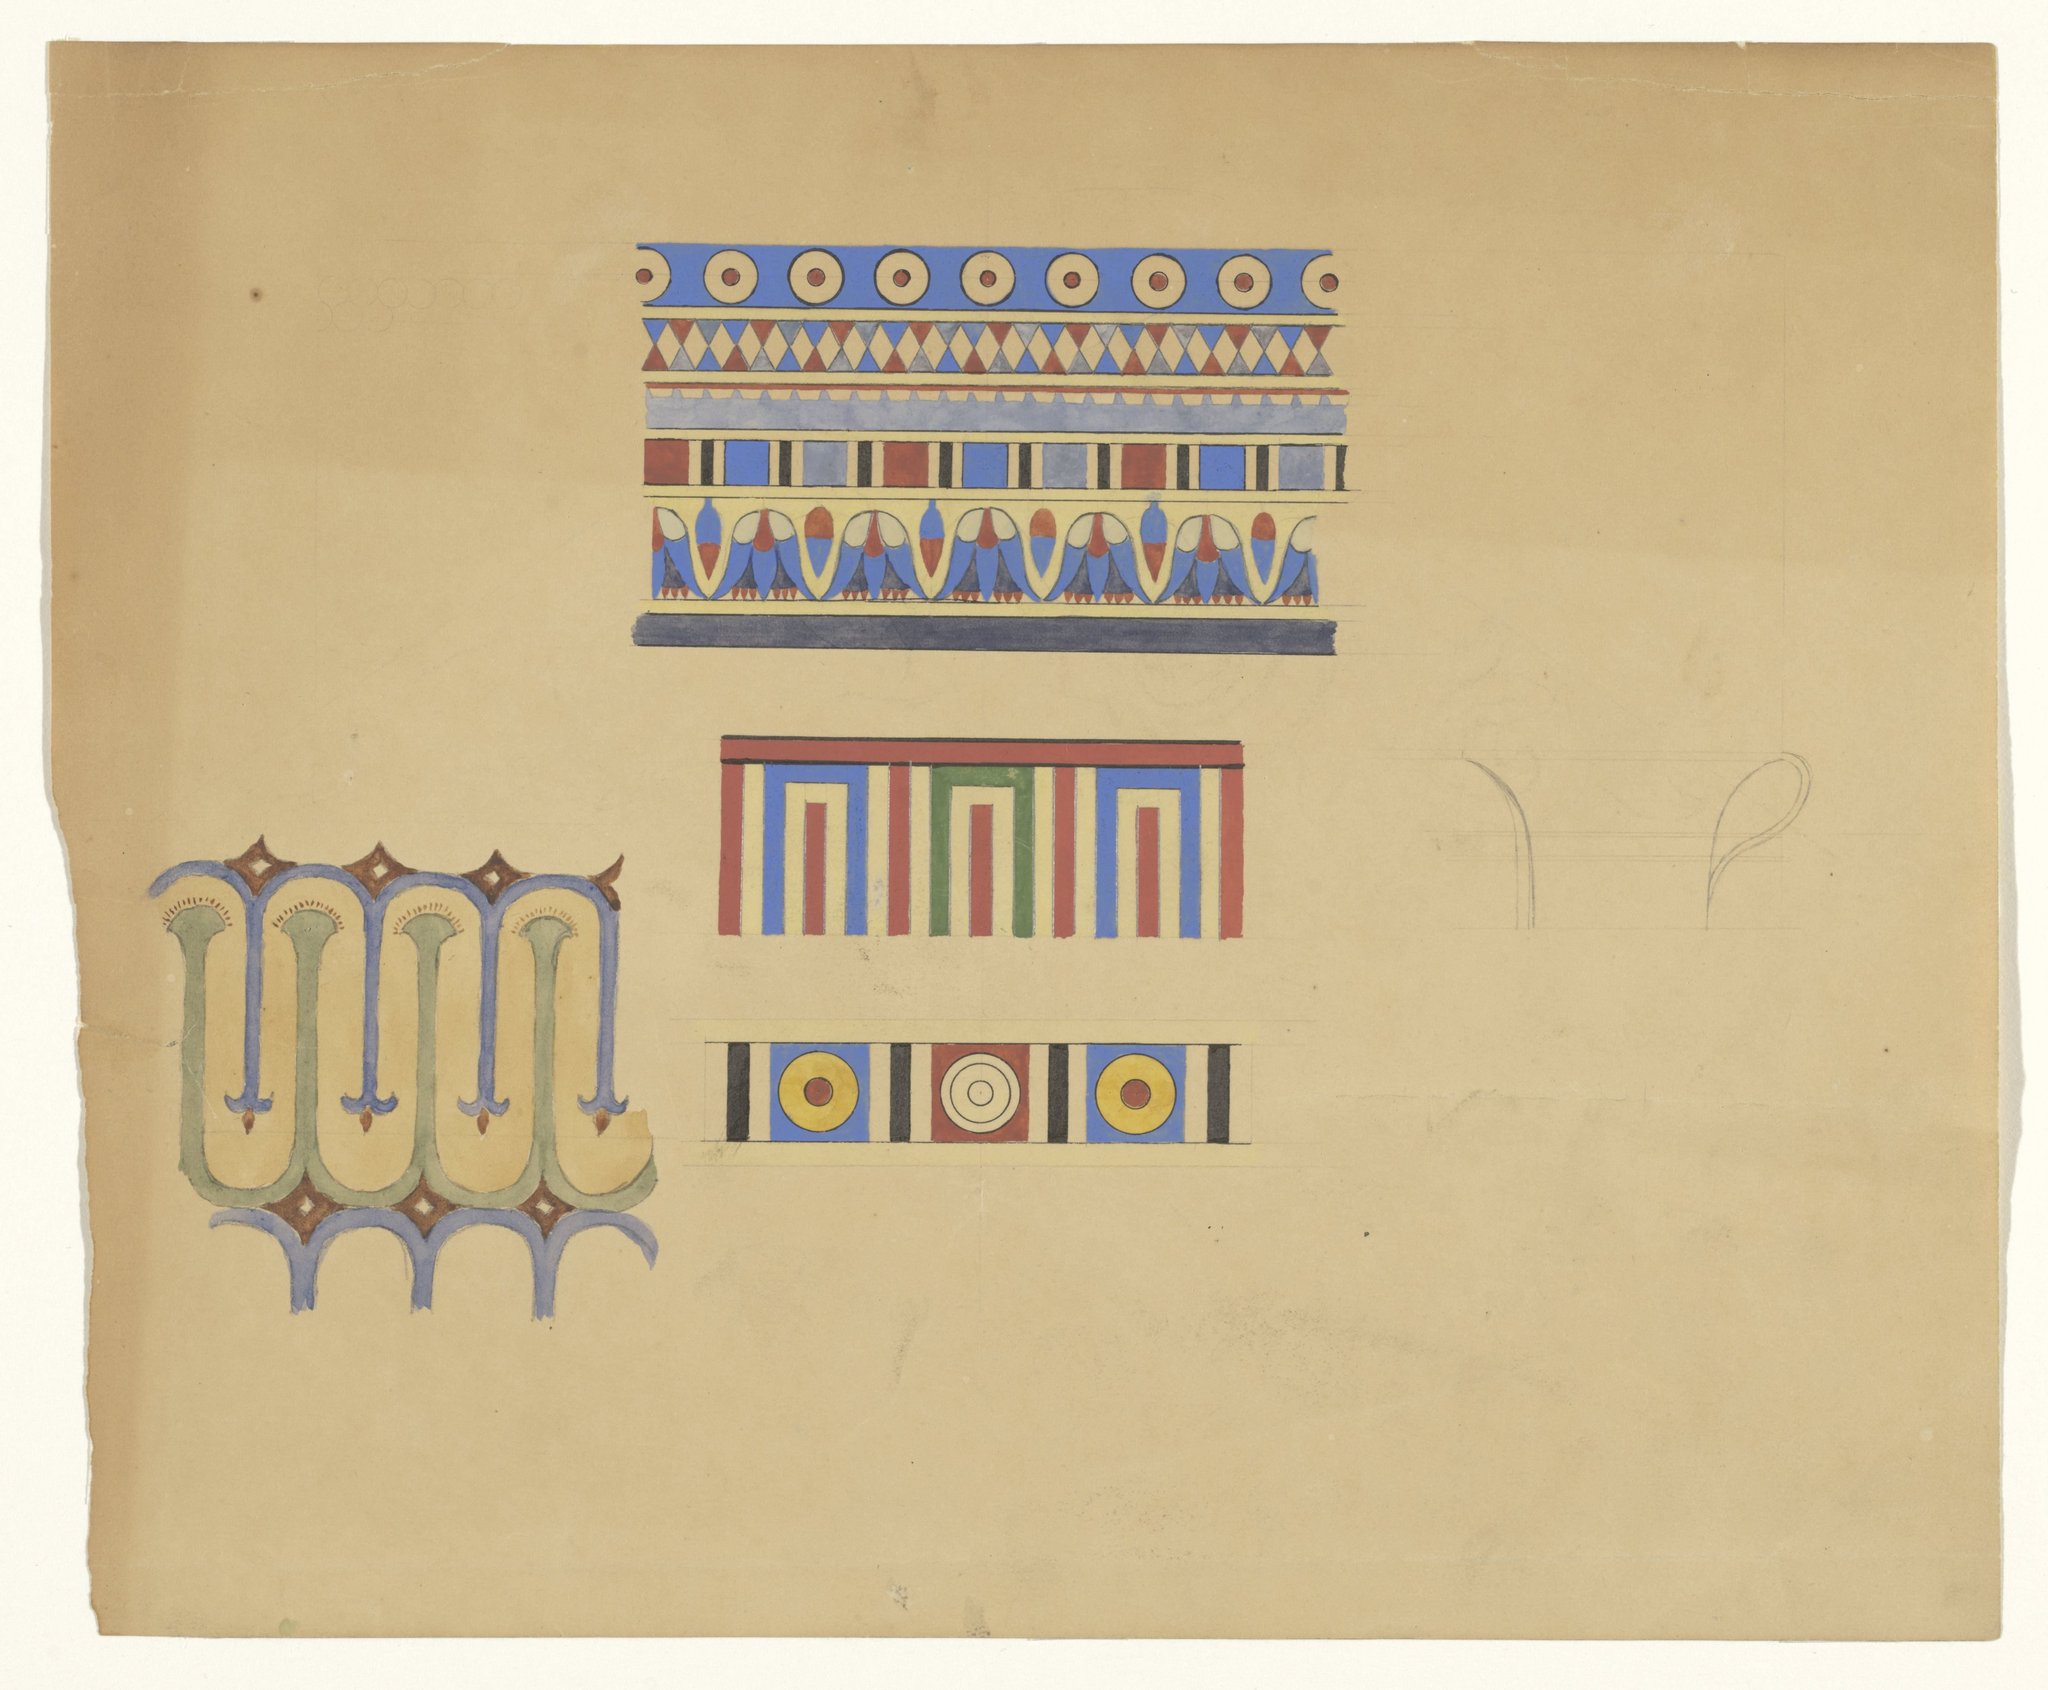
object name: drawing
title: Details van friezen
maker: franz jakob kreuter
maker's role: architect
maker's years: 1813-1889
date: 1835-1860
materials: paper, pencil, watercolor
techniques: brush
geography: munich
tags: frequently used ornamental compositions